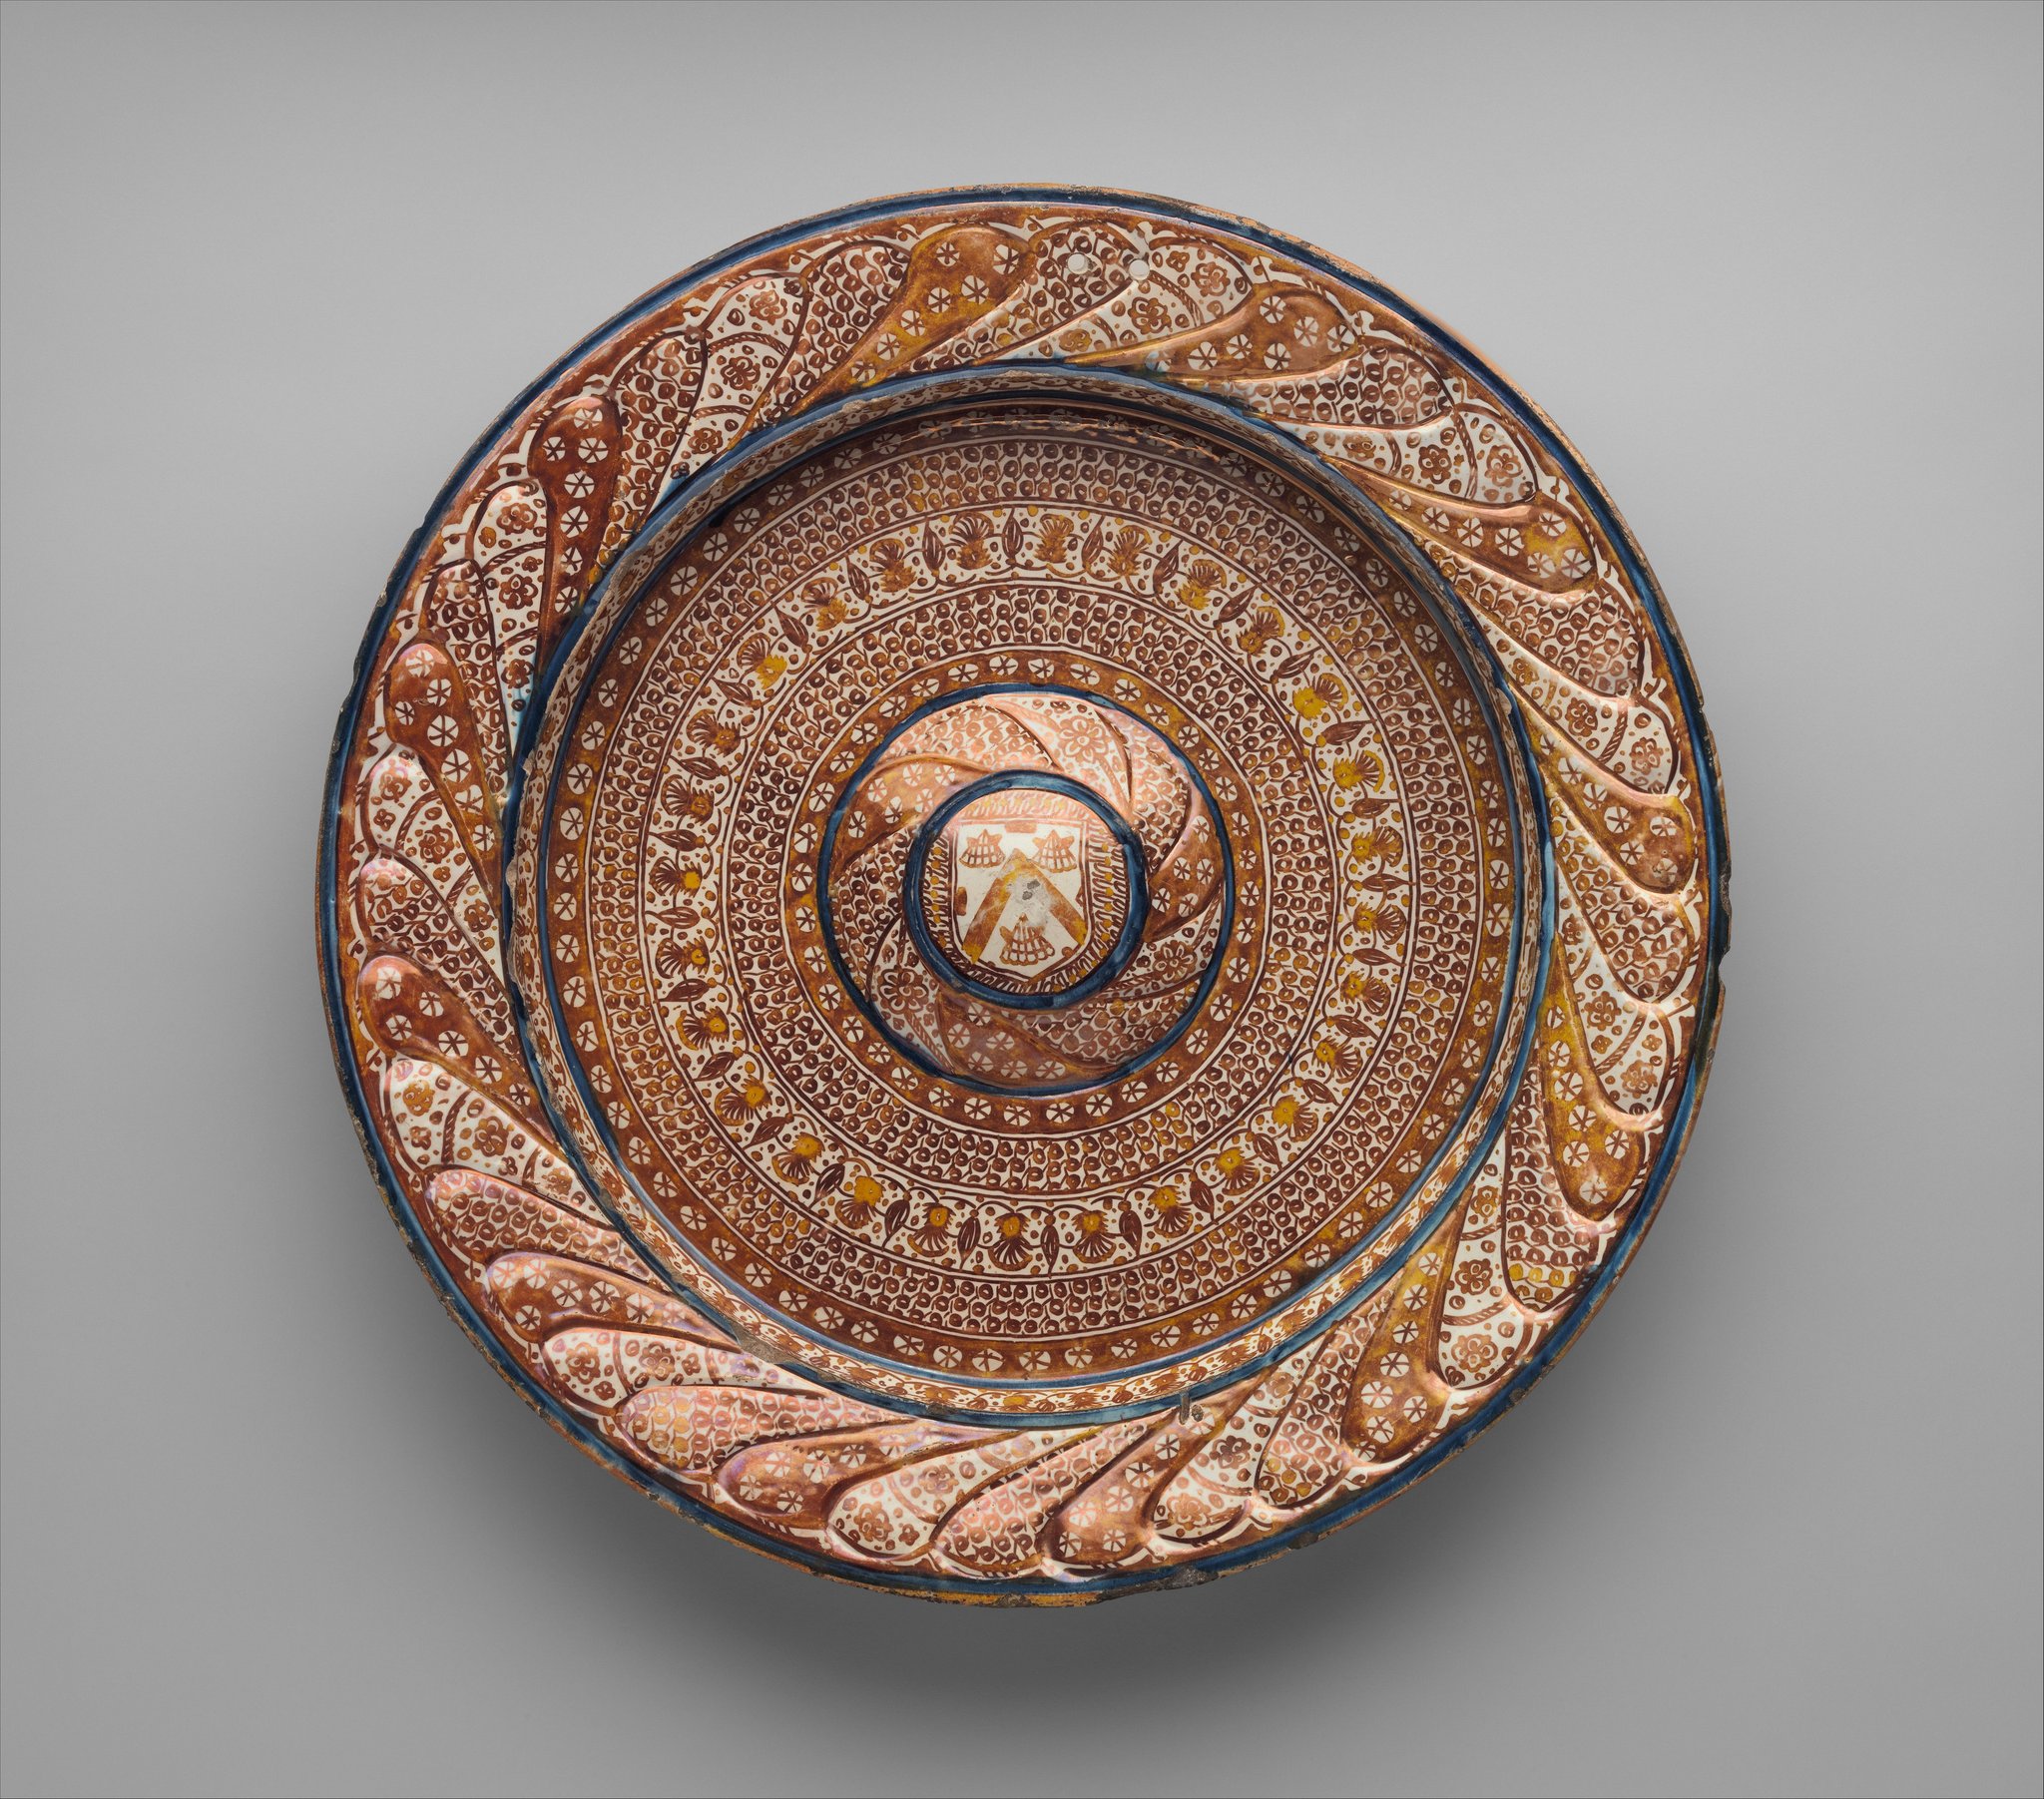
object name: dish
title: Deep Dish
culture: spanish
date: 1467-1533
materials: earthenware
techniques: glazing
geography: spain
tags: leaves,coat of arms